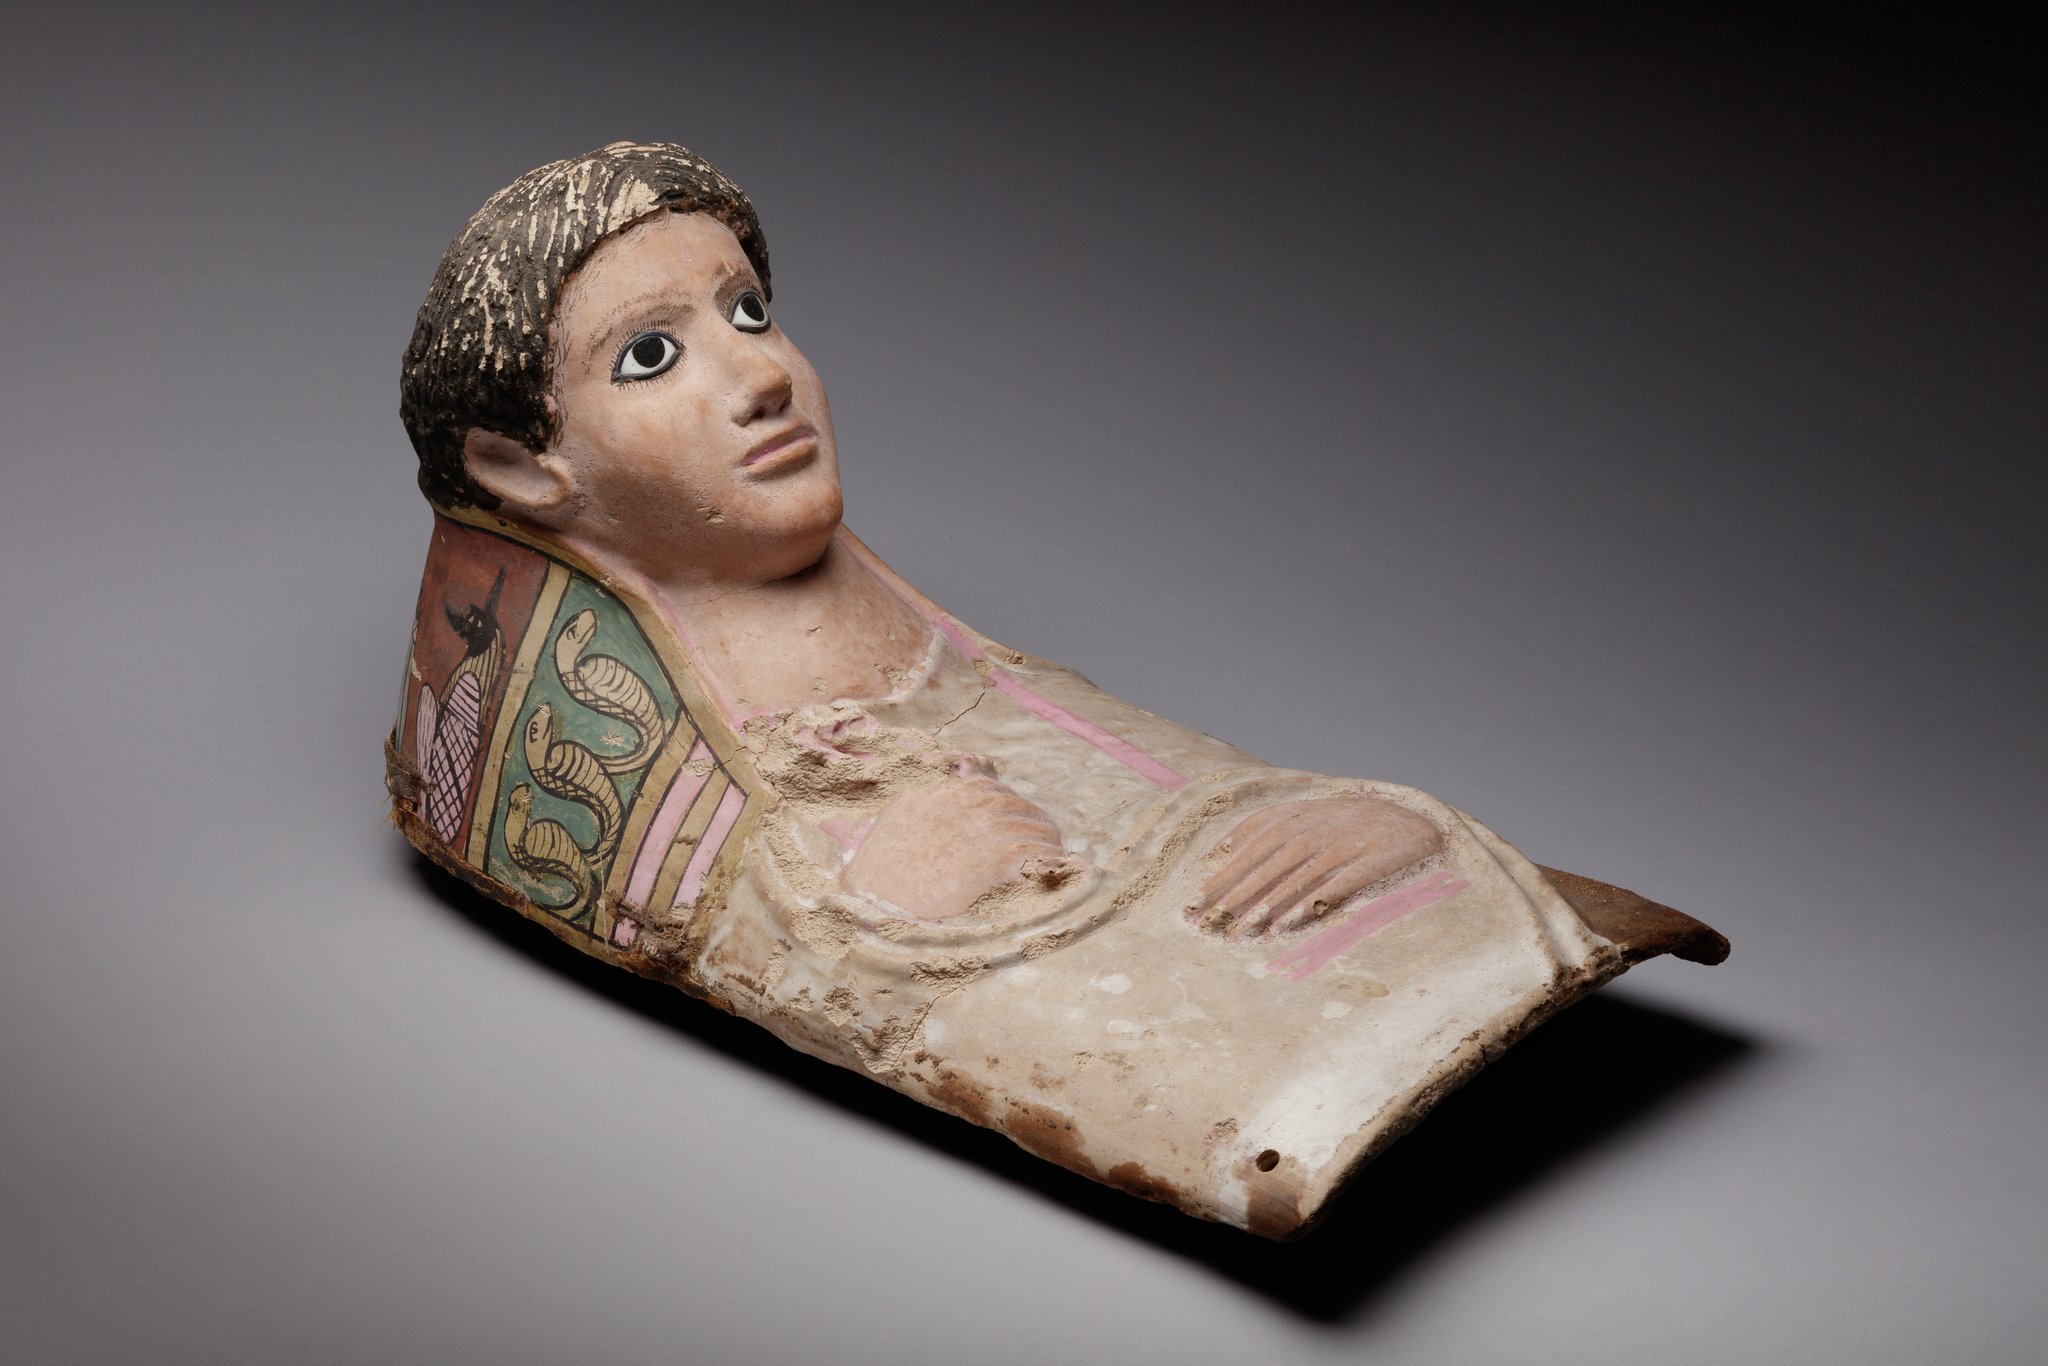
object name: mask, youth portrait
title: Plaster Portrait Mask of a Youth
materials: glass, lapis lazuli, linen, paint, plaster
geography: middle egypt